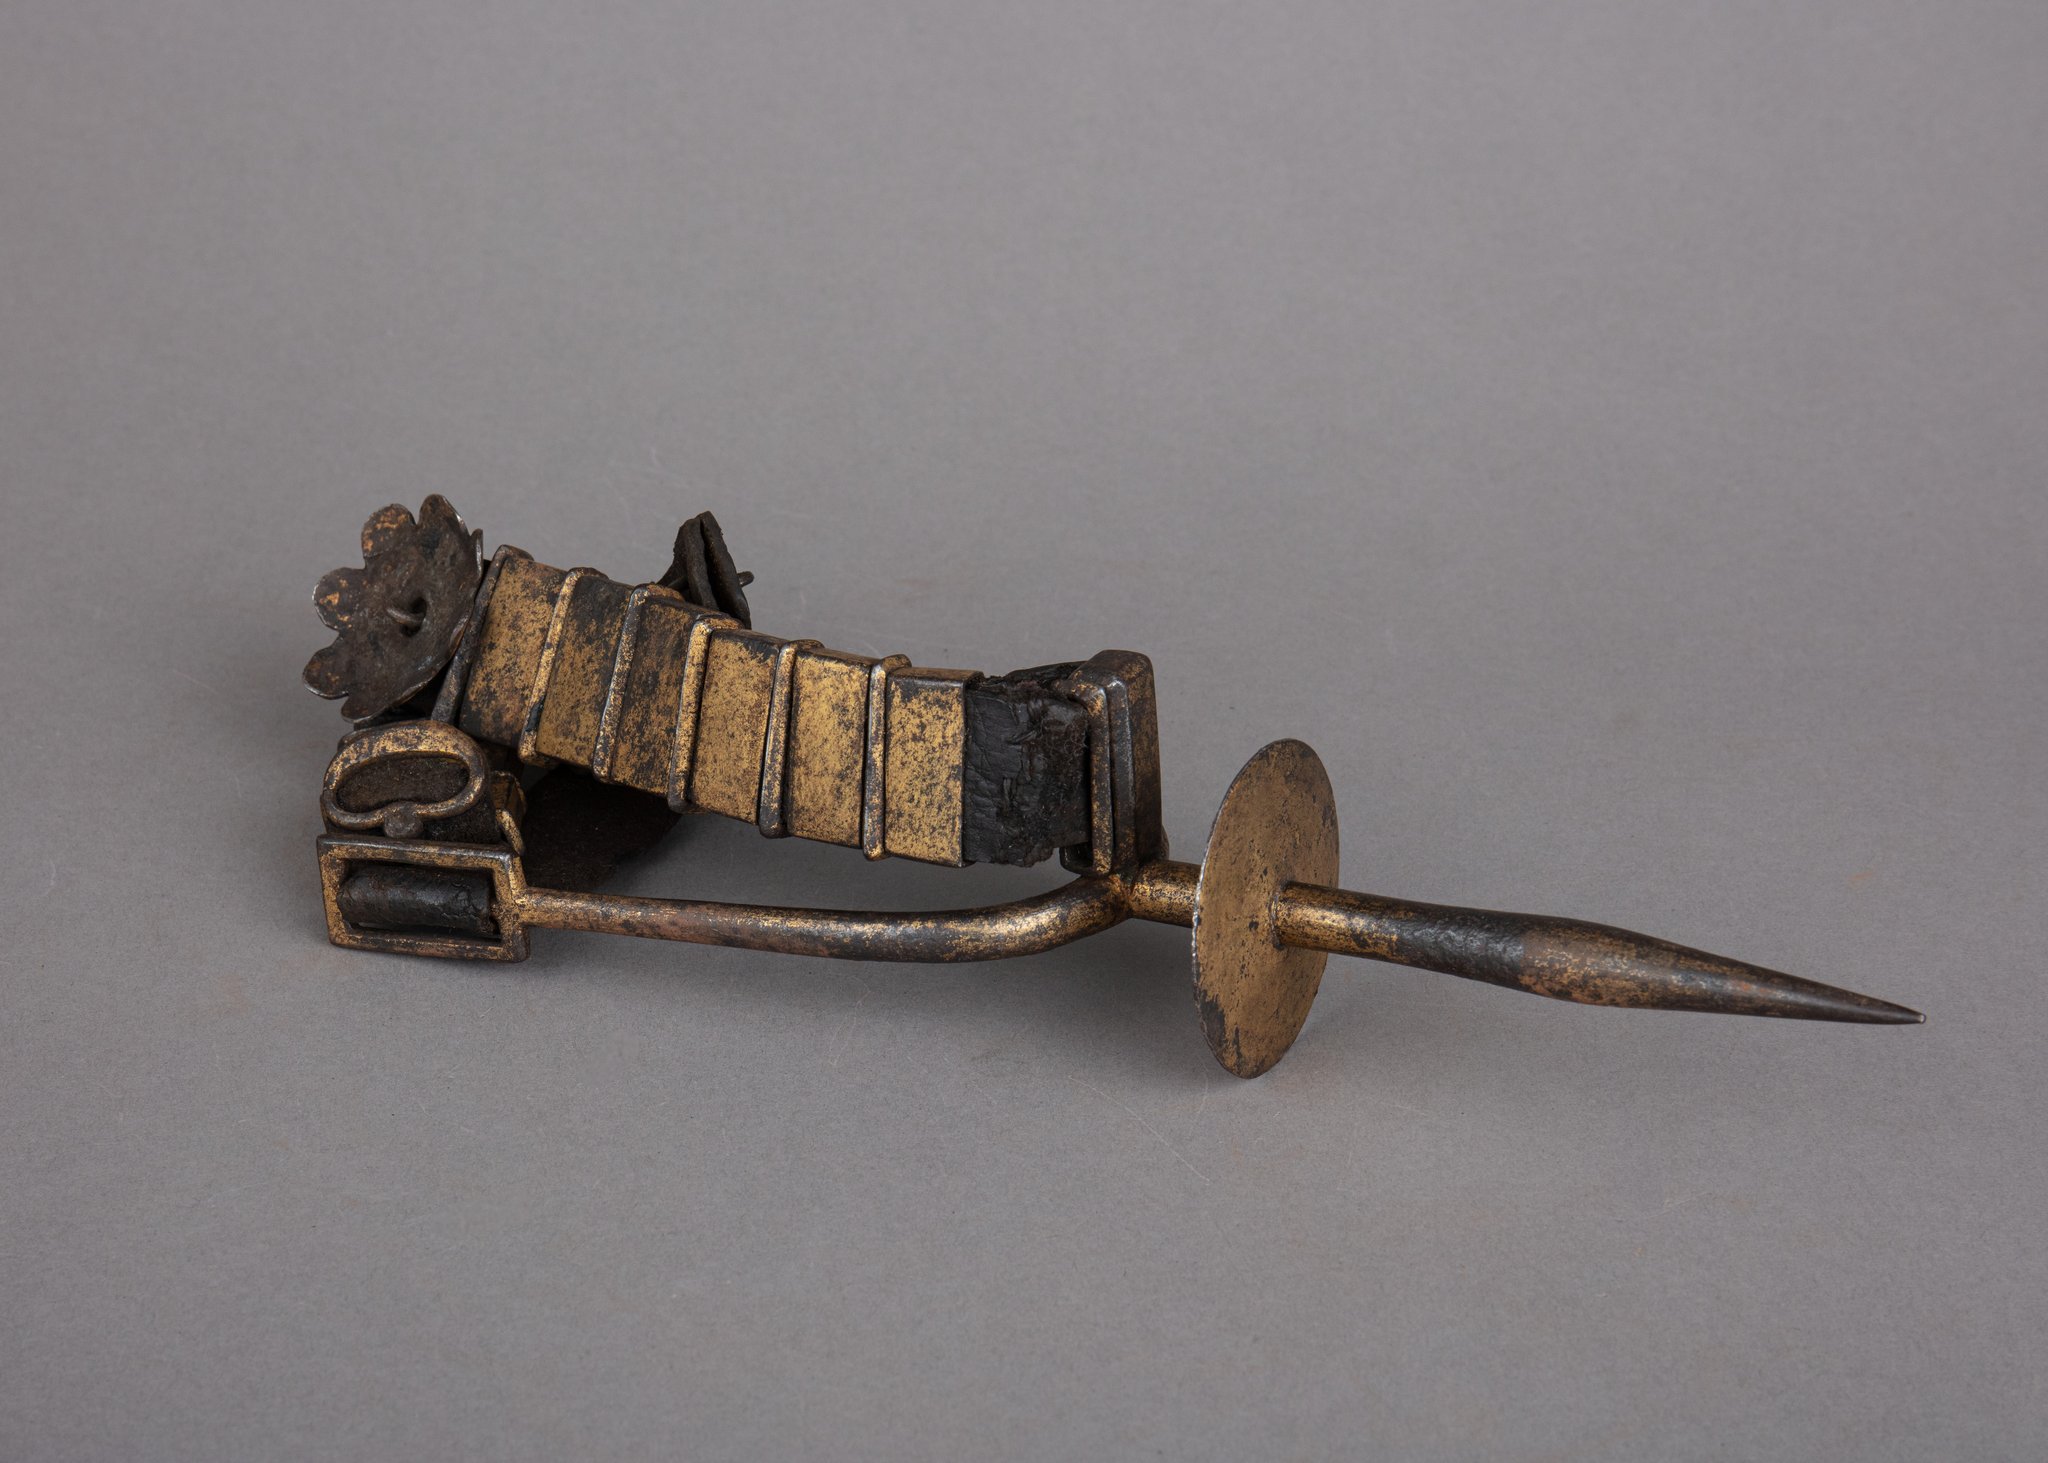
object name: spur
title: Prick Spur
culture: moroccan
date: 1701-1900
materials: gold, iron, metal alloy, leather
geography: morocco